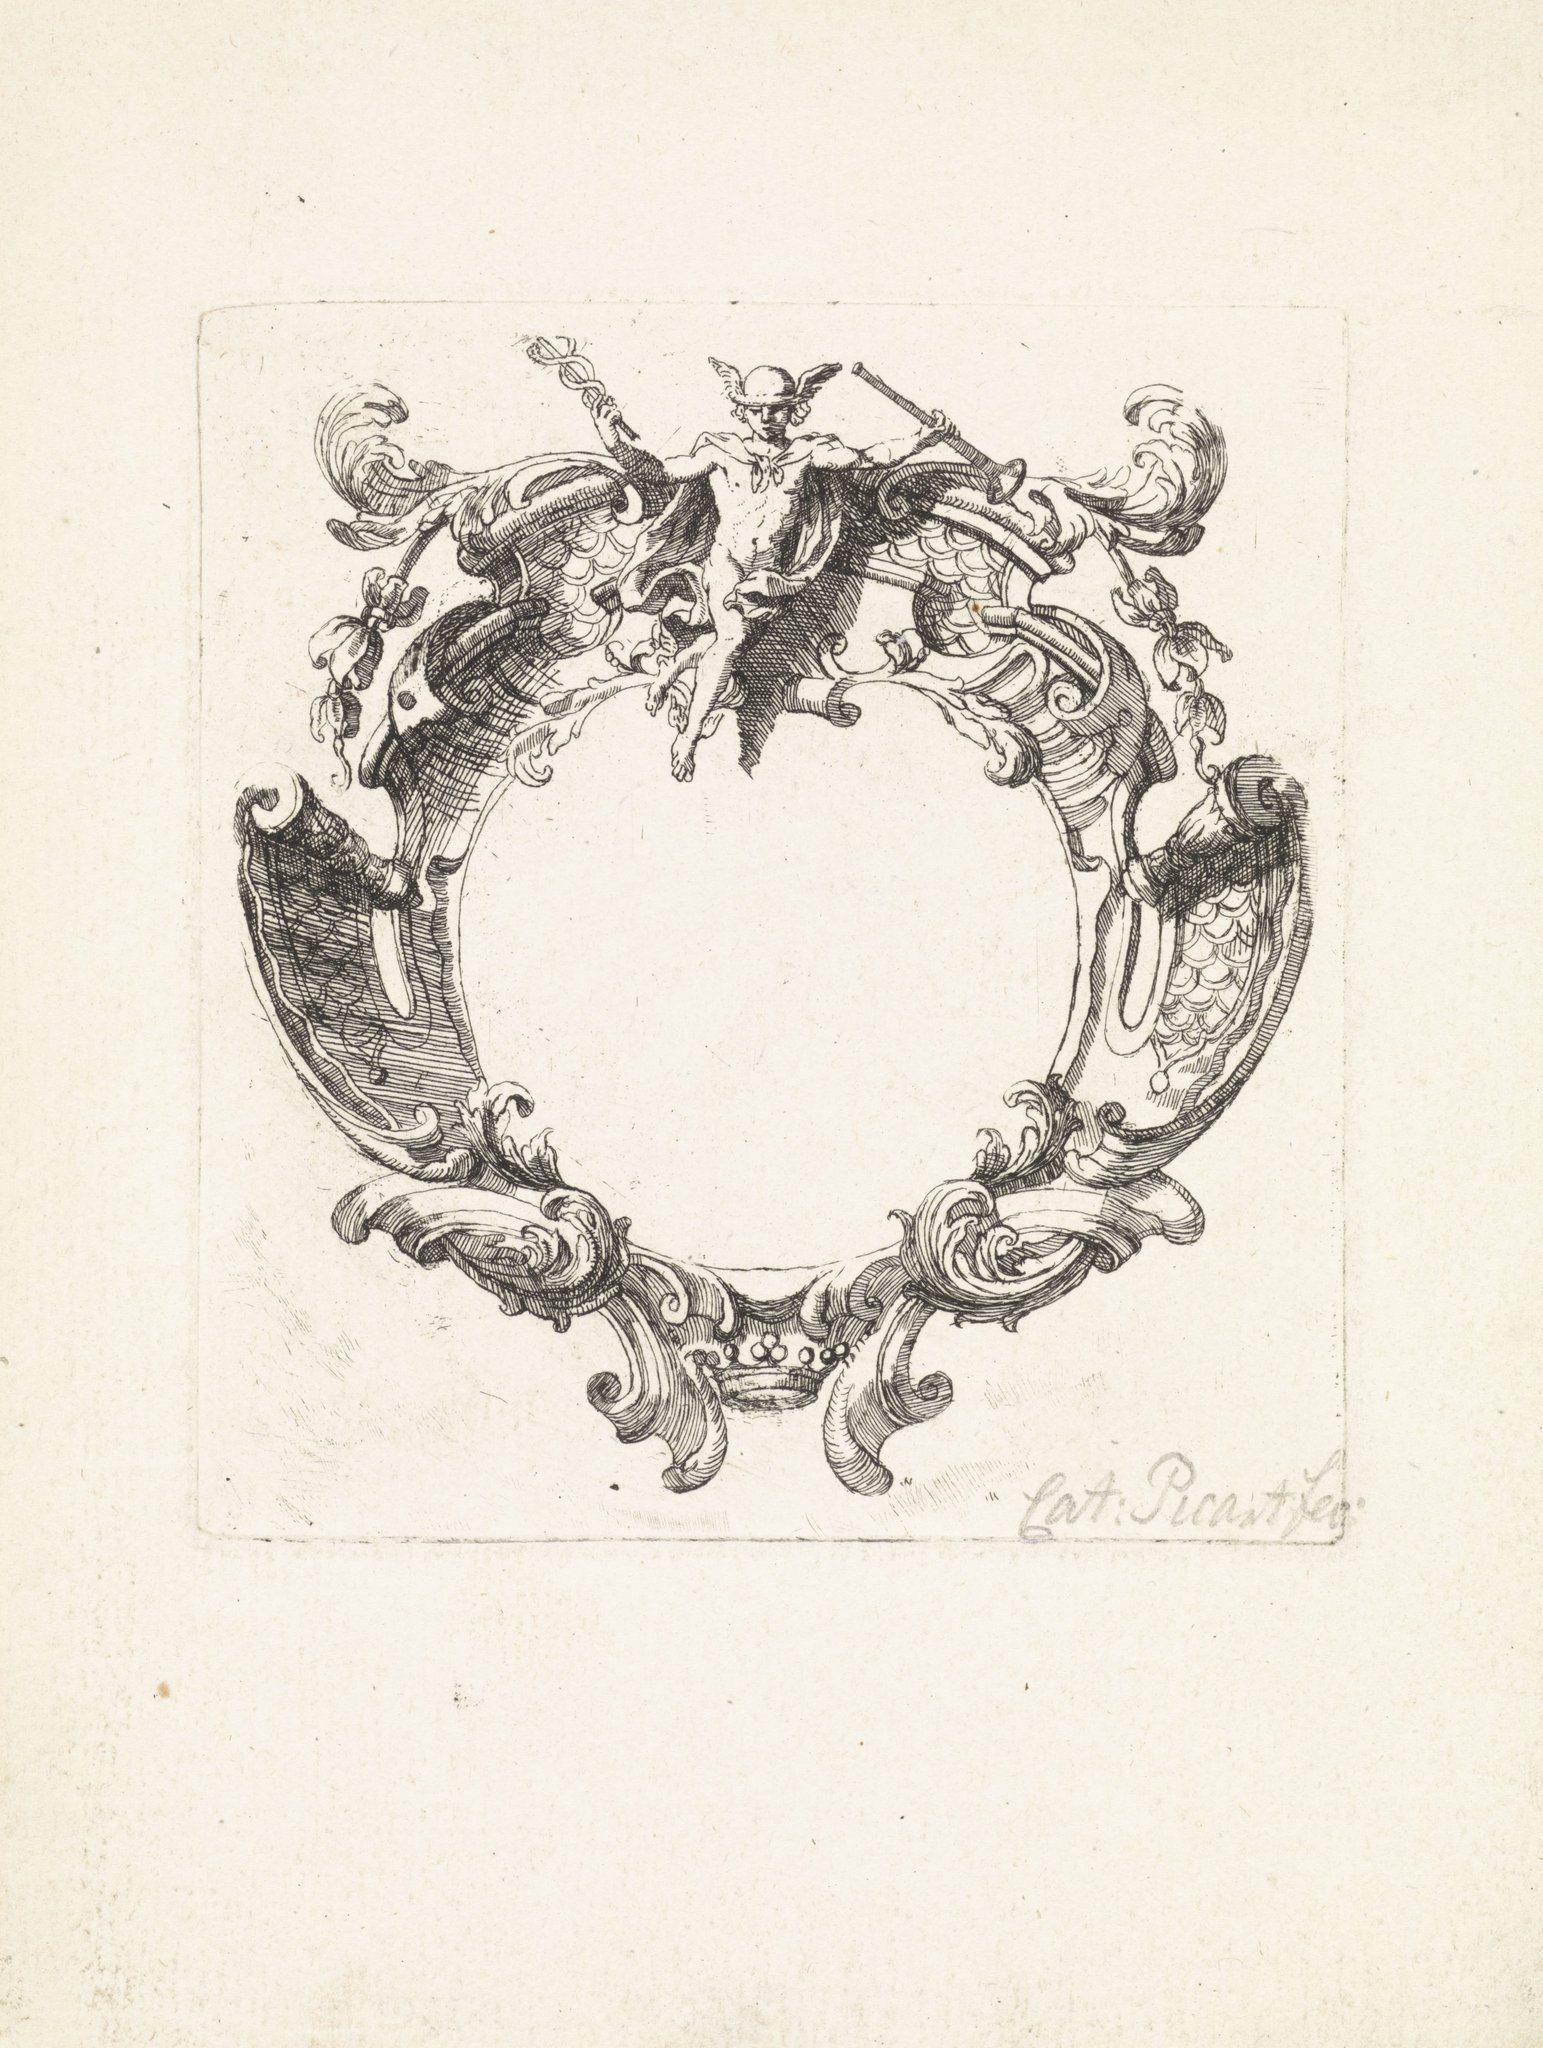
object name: print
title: Ornamenteel cartouche met Mercurius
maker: Anonymous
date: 1683-1783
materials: paper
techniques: etching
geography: netherlands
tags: ornaments ~ art, (story of) mercury (hermes), ornament ~ cartouche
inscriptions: collector's mark: Lugt 2233, inscription: ‘Cat: Picart fec.’